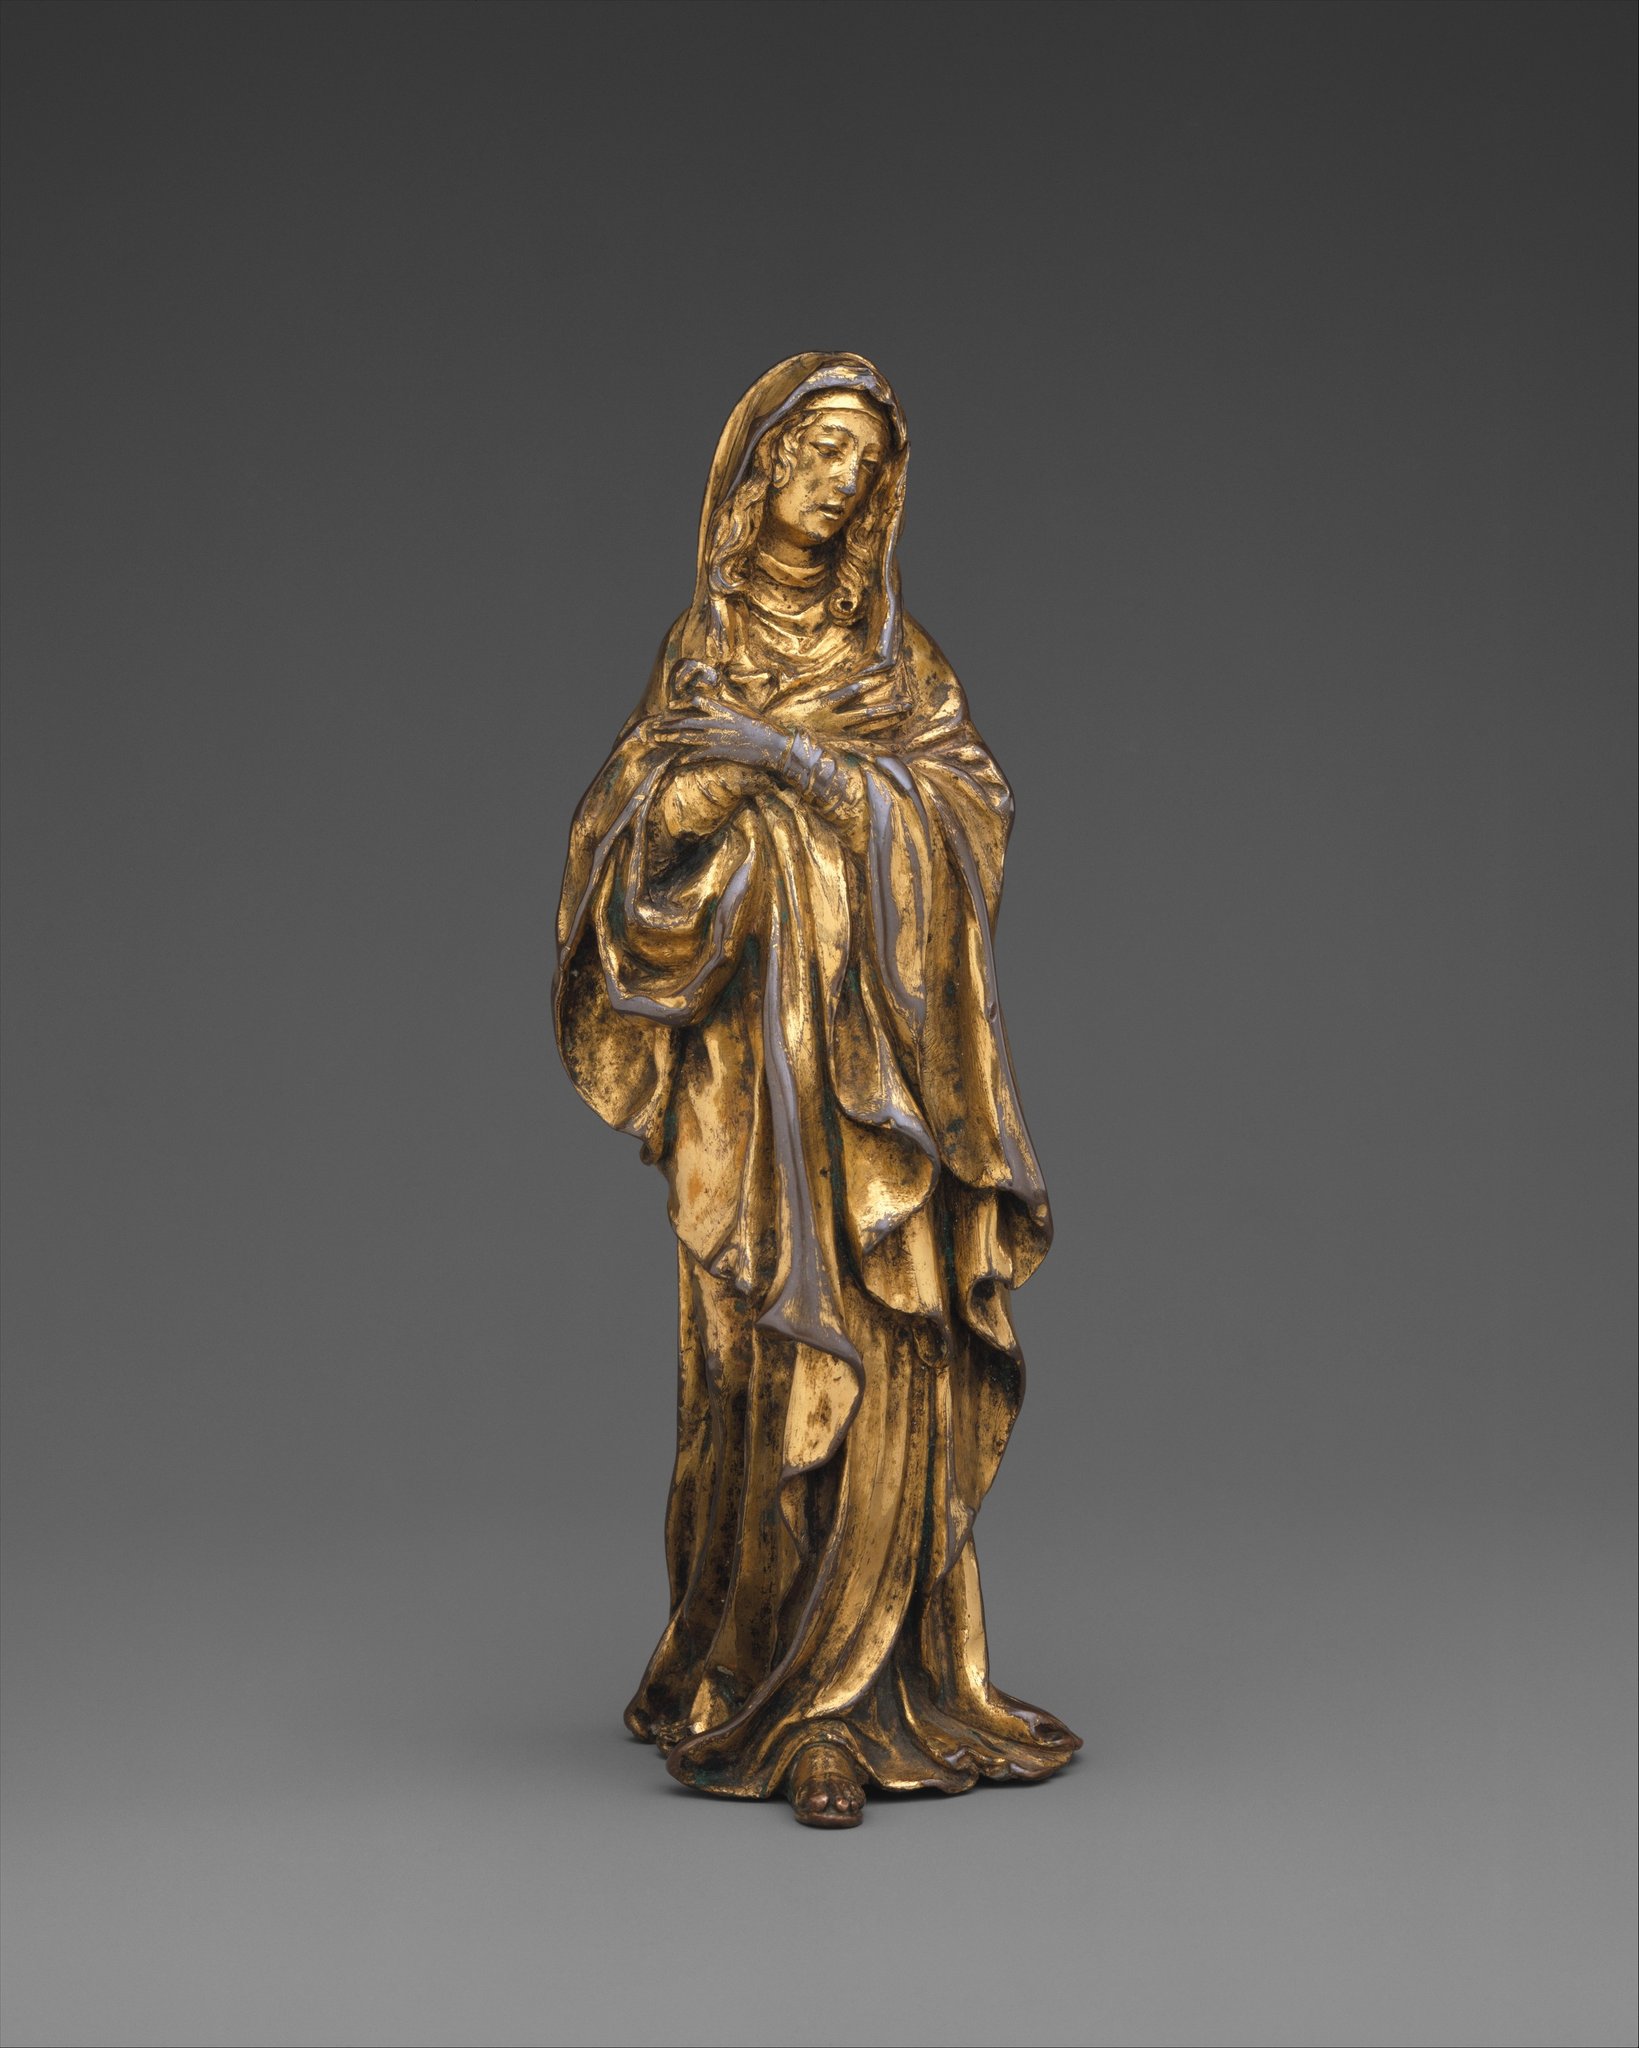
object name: statuette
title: The Virgin Mary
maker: germain pilon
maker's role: artist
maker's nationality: french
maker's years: 1525-1590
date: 1585-1590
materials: gilt bronze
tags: virgin mary